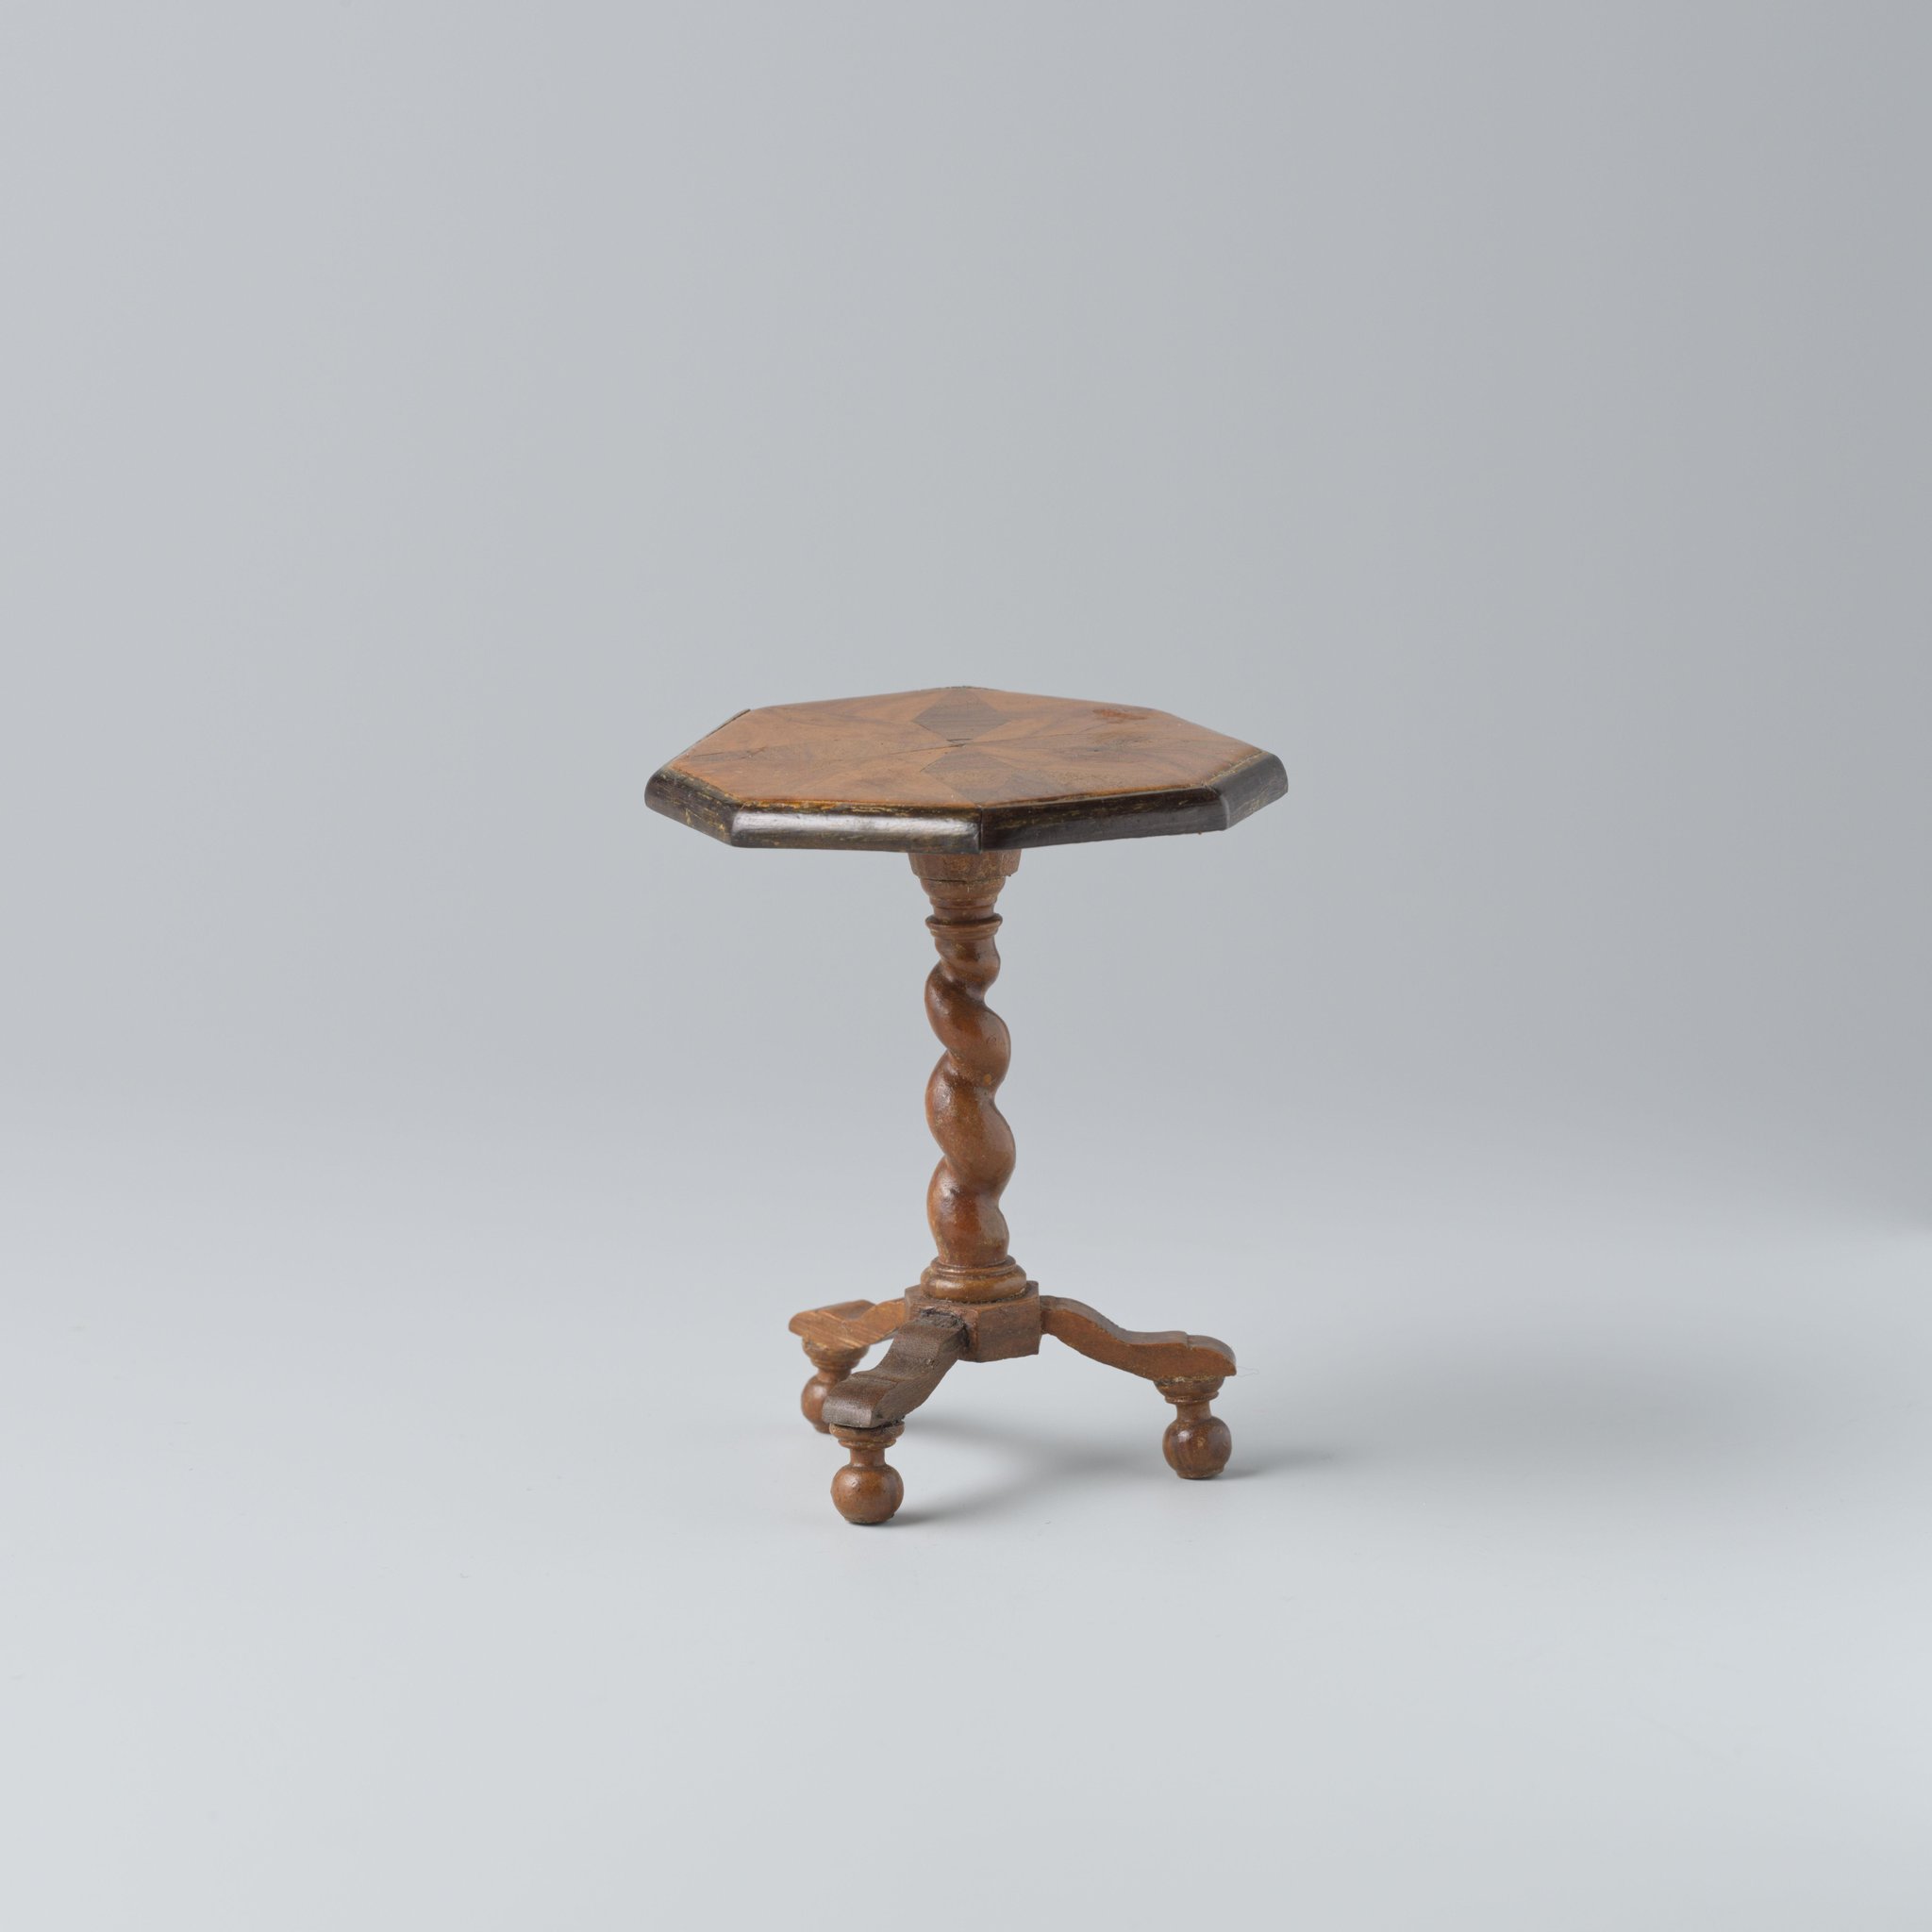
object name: miniature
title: Gueridon met achthoekig blad met sterpatroon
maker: Anonymous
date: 1676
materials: wood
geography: amsterdam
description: Gueridon met achthoekig blad, belijmd met olijfhout in een sterpatroon op een kern van eikenhout. De rand afgezet met ebbenhout. Het blad rust op een getorste poot van olijfhout, op een voet bestaande uit drie straalsgewijs geplaatste, licht gebogen steunen, rustend op drie bolpoten.